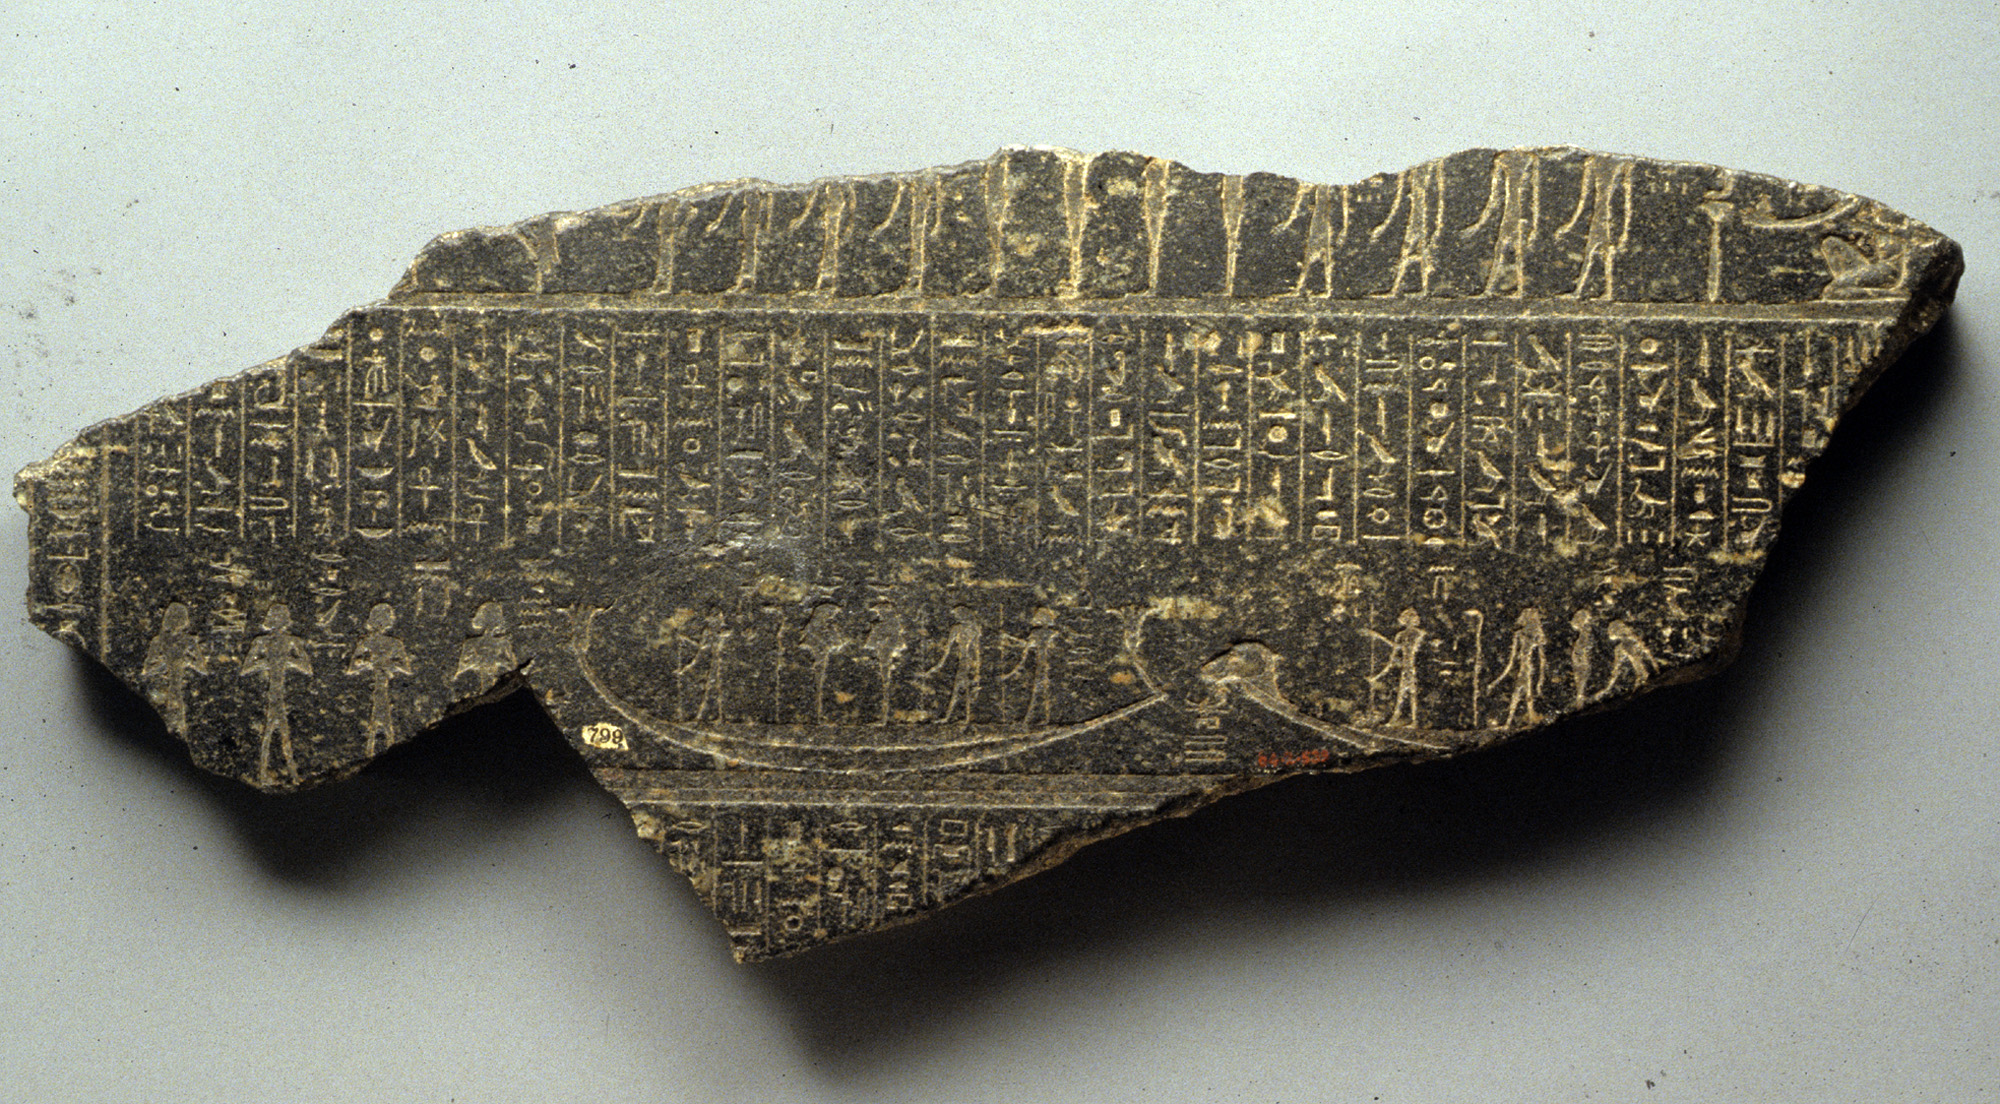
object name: fragment from the sarcophagus of usermaatre, son of djedkhonsuefankh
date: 360-300 BCE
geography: egypt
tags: hieroglyphs,sarcophagus